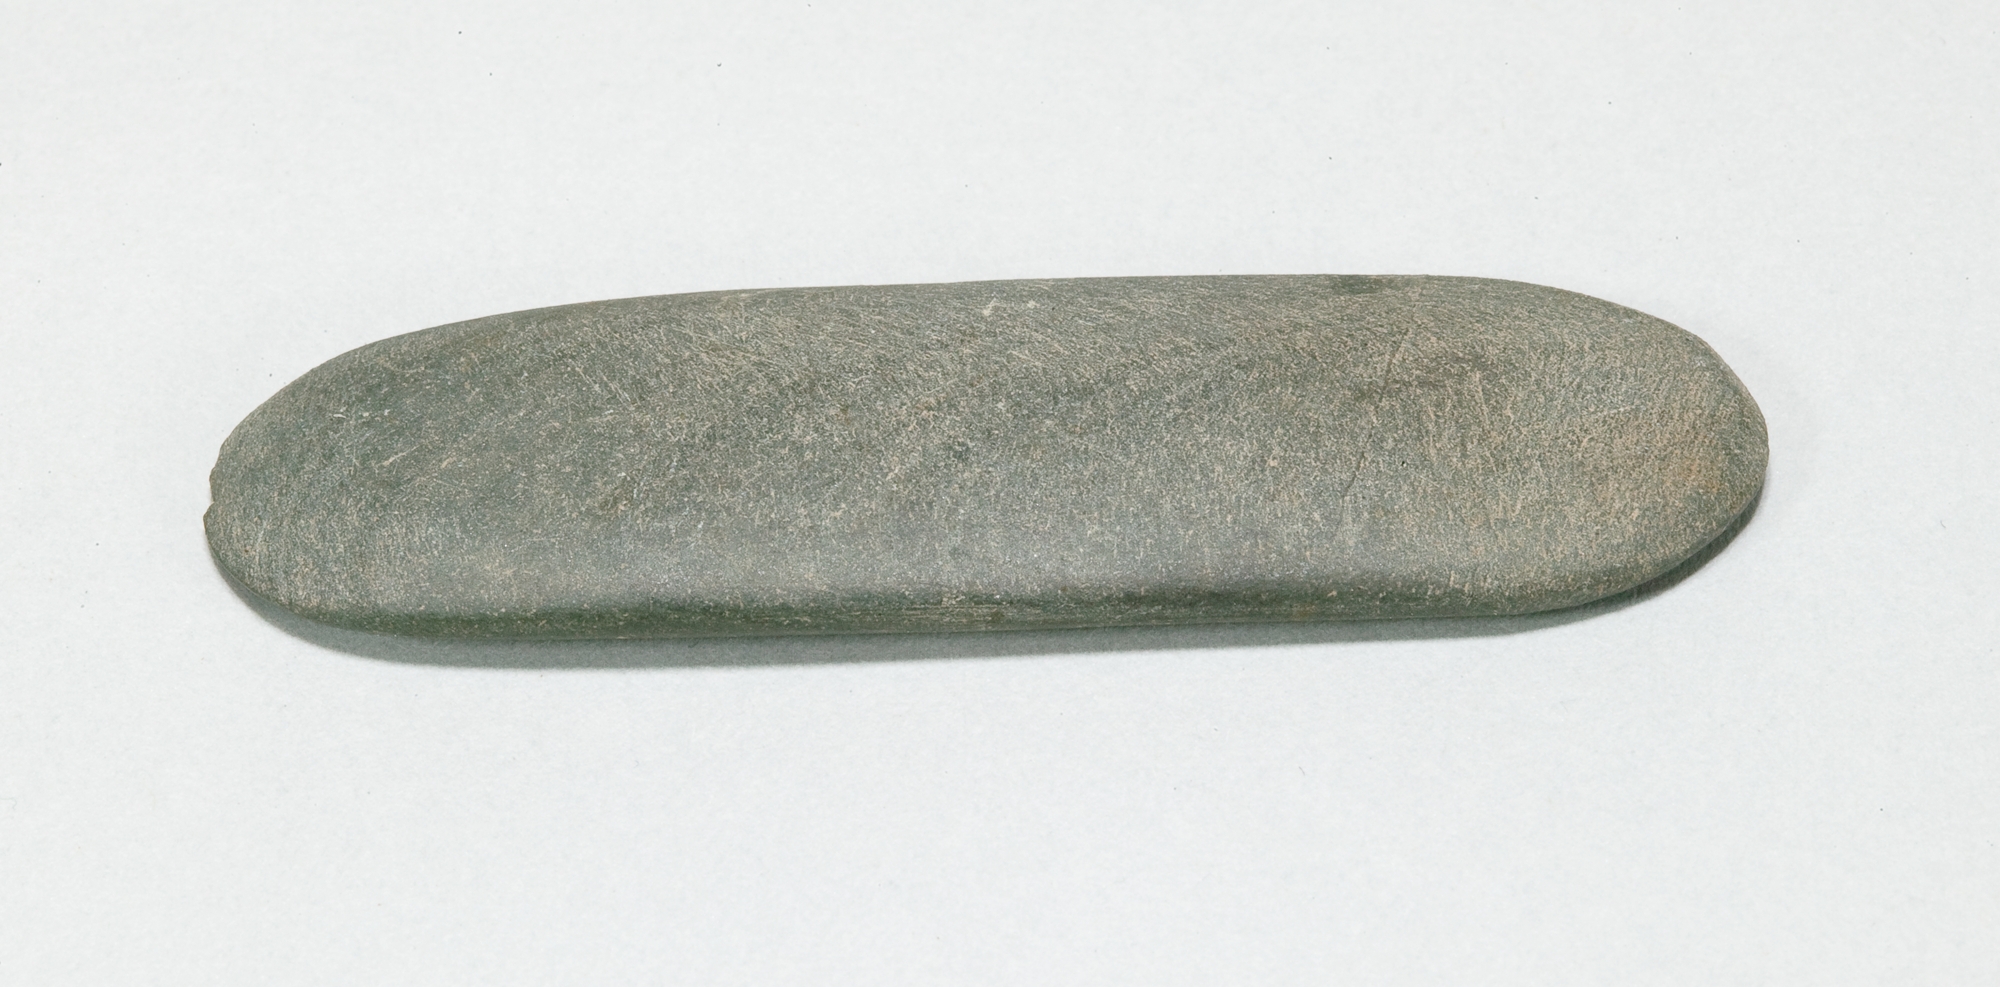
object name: spatula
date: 1981-1640 BCE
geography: egypt